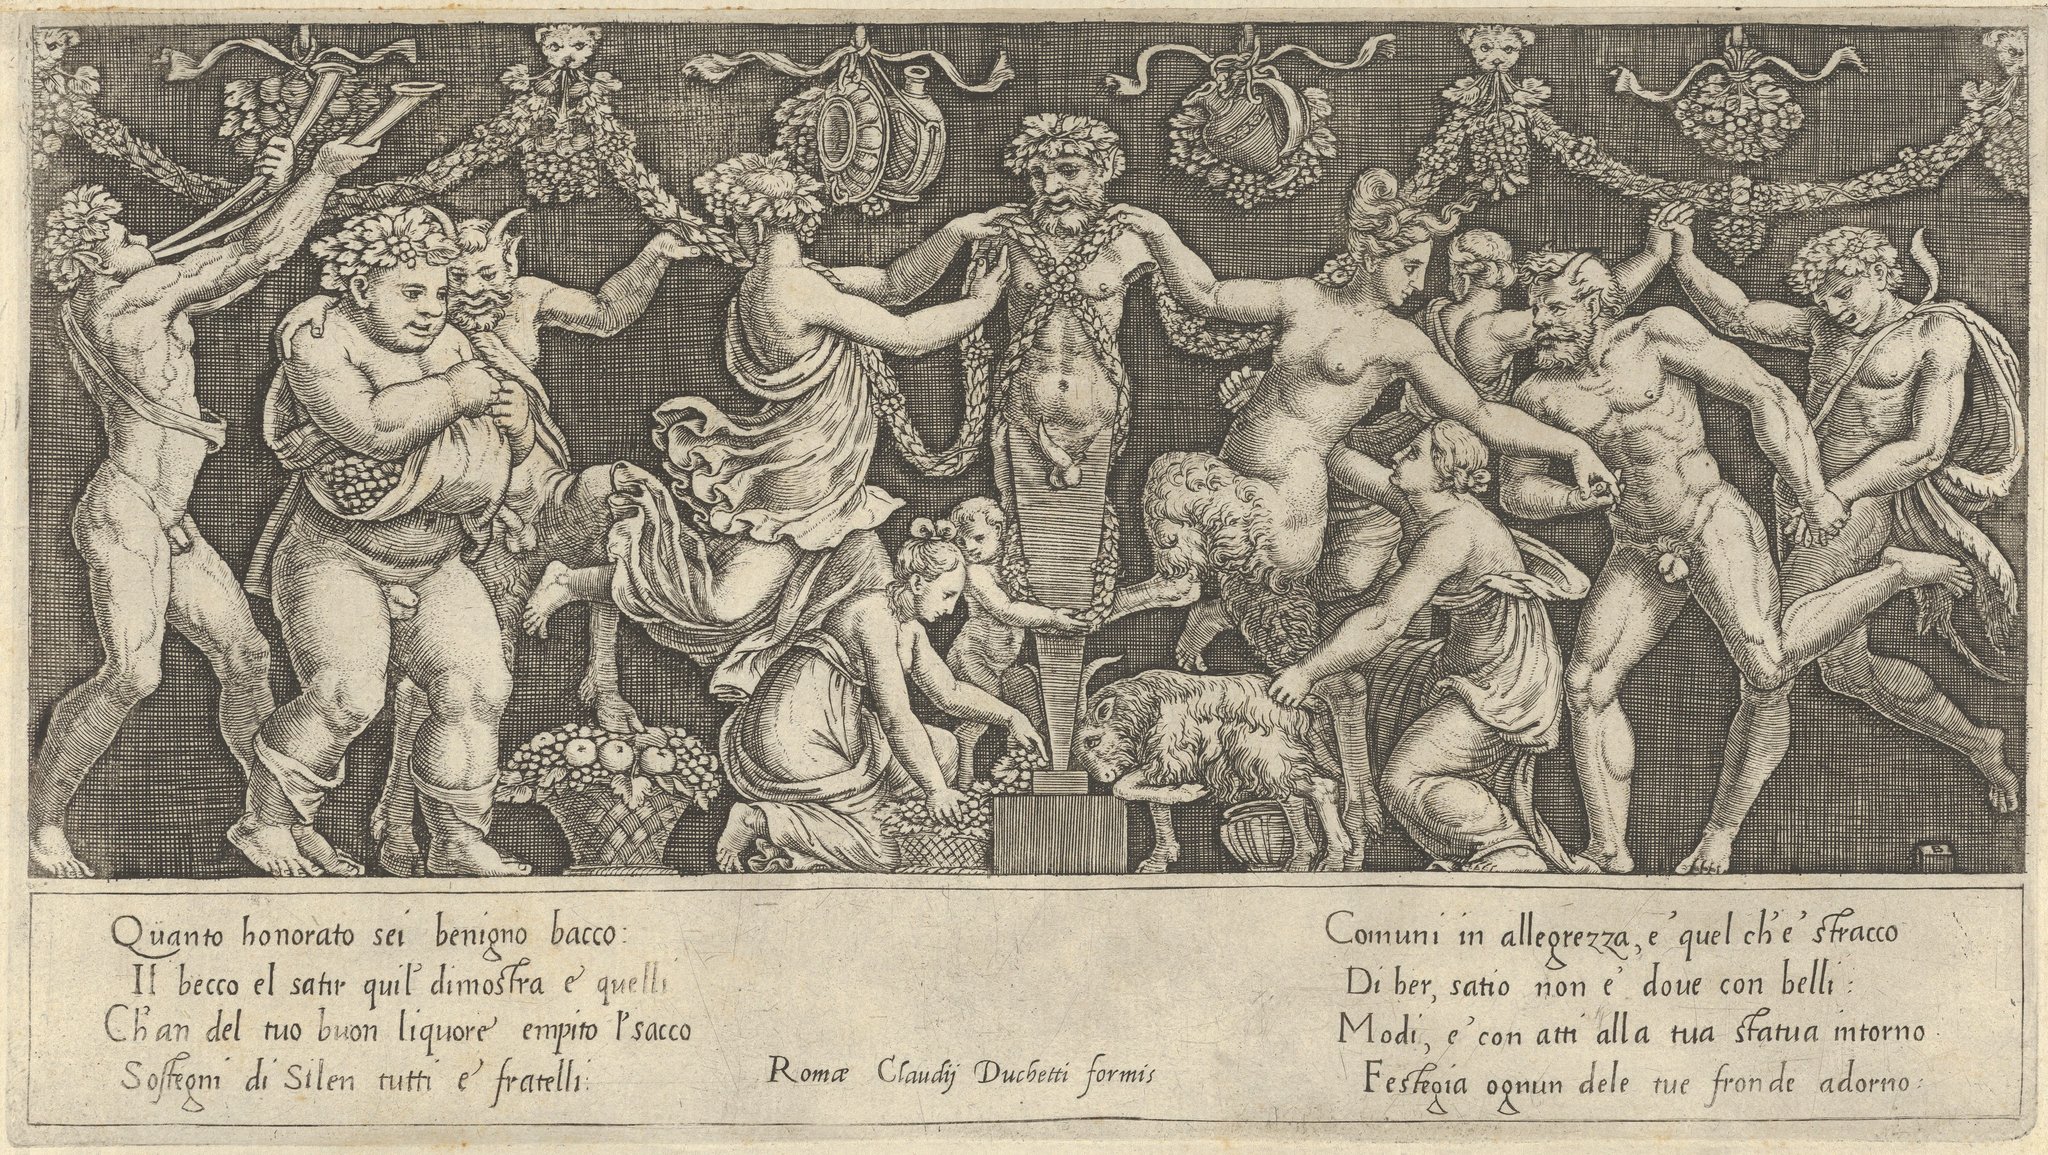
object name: print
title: Sacrifice to Priapus, from "Speculum Romanae Magnificentiae"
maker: master of the die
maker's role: artist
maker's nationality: italian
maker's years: 1525-1560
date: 1501-1600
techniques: engraving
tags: male nudes,female nudes,satyrs,goats